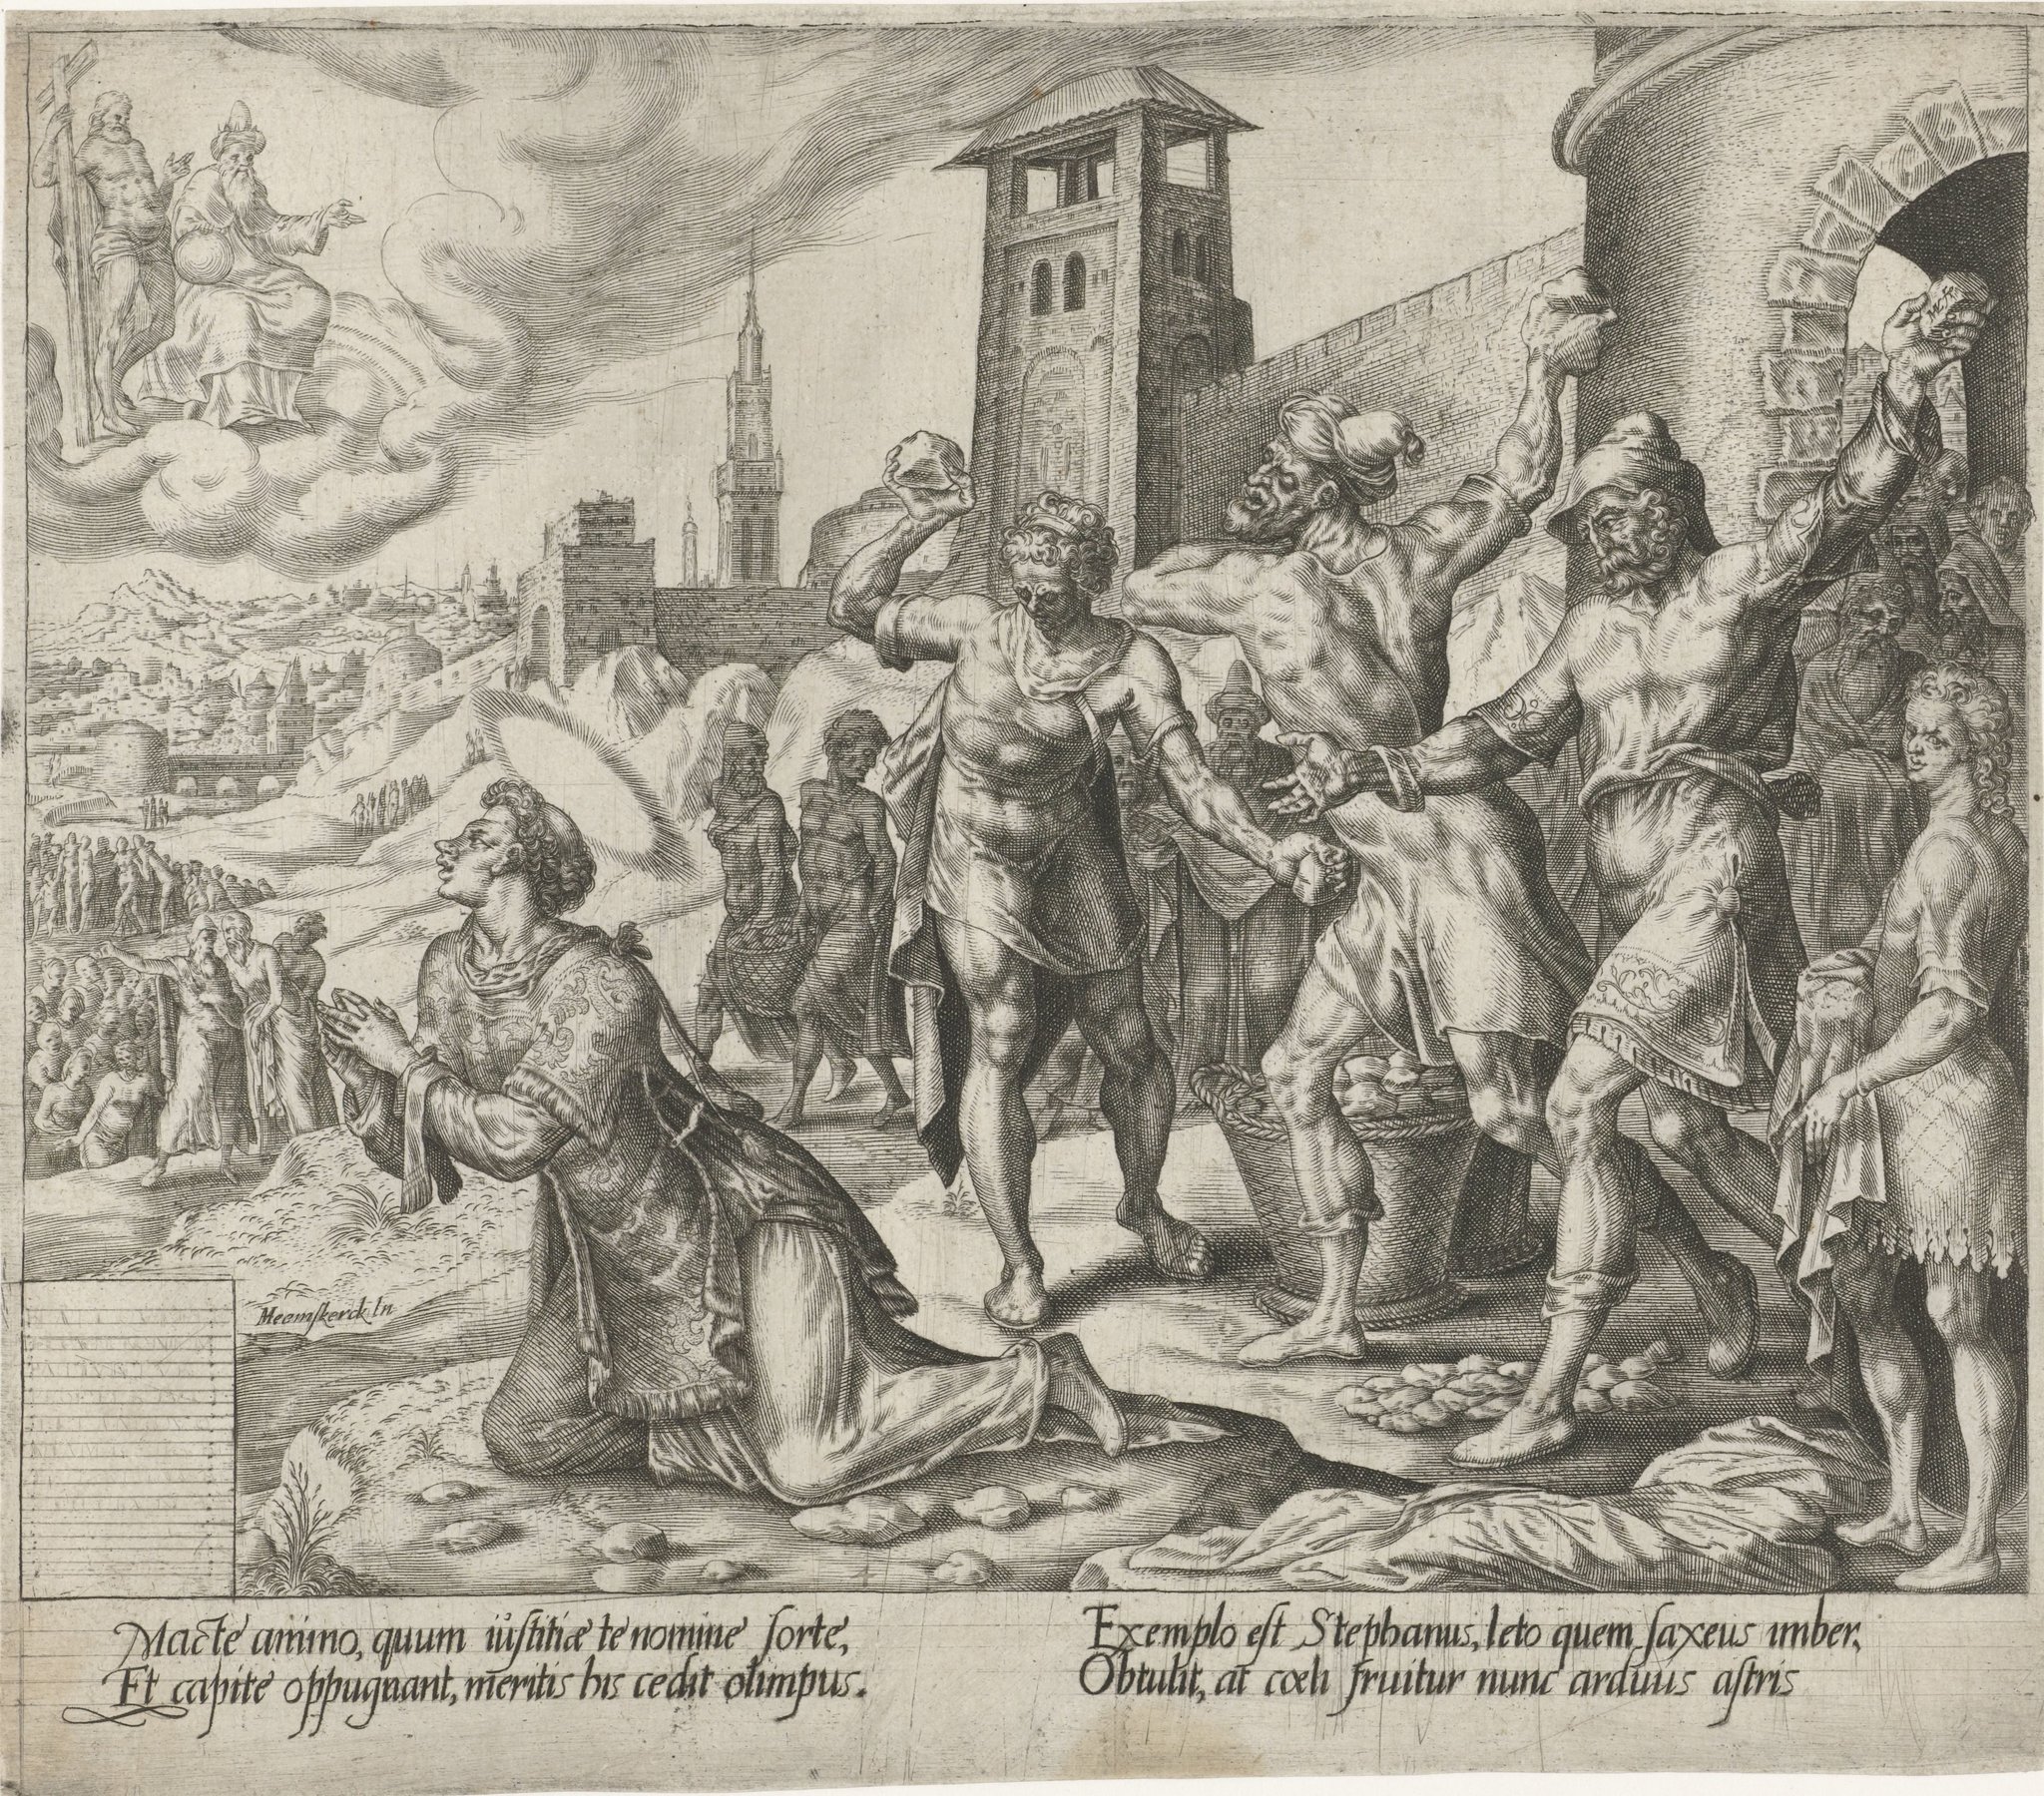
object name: print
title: Zalig wie vanwege de gerechtigheid vervolgd worden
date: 1564-1568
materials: paper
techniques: engraving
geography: amsterdam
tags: blessed are those who are persecuted for righteousness' sake, the stoning of stephen; the witnesses lay down their clothes at saul's feet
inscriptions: collector's mark: Lugt 2228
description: Stefanus wordt buiten de stadspoort gestenigd. Rechts staat Saulus met de mantels van degenen die stenen gooien. Op de wolken ziet Stefanus in een visioen God de Vader en Christus. Prent maakt deel uit van een serie over de acht zaligsprekingen van Christus en illustreert de zaligspreking: Zalig wie vanwege de gerechtigheid vervolgd worden. Onderaan in de marge een vers in het Latijn over de zaligspreking en de voorstelling.